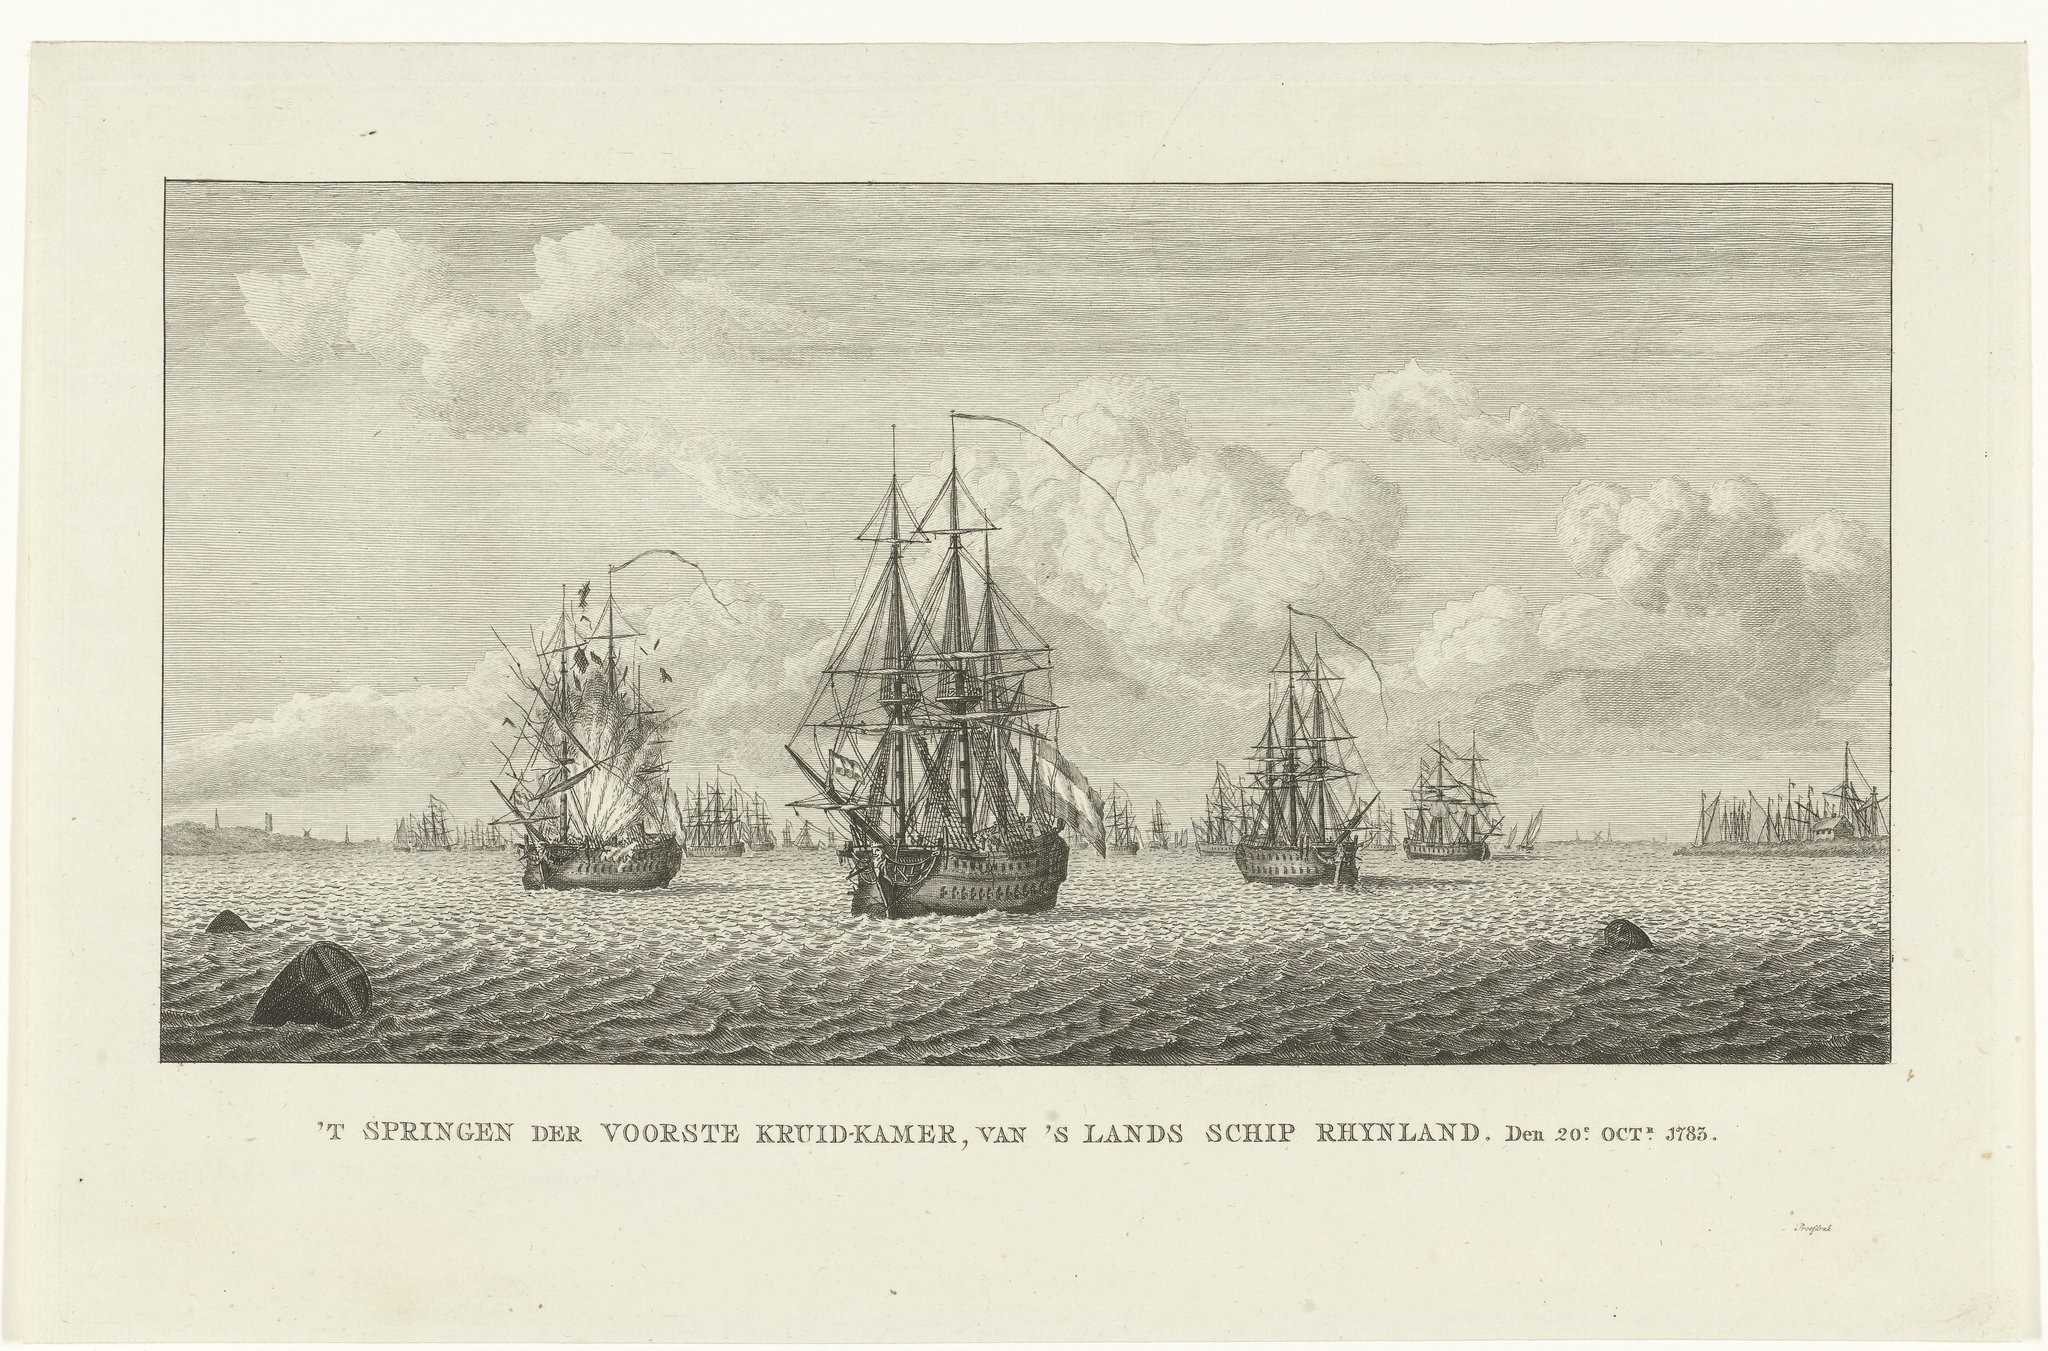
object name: print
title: Voorste kruitkamer van schip Rhijnland ontploft op 20 oktober 1783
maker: carel frederik bendorp (i)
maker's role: print maker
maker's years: 1736-1814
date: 1783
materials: paper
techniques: etching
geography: netherlands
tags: ships (in general), gunpowder disaster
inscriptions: collector's mark: Lugt 2228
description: Schepen liggen voor anker op rustig water voor de kust. Op het schip Rhijnland vindt een explosie van kruit plaats op 20 oktober 1783.